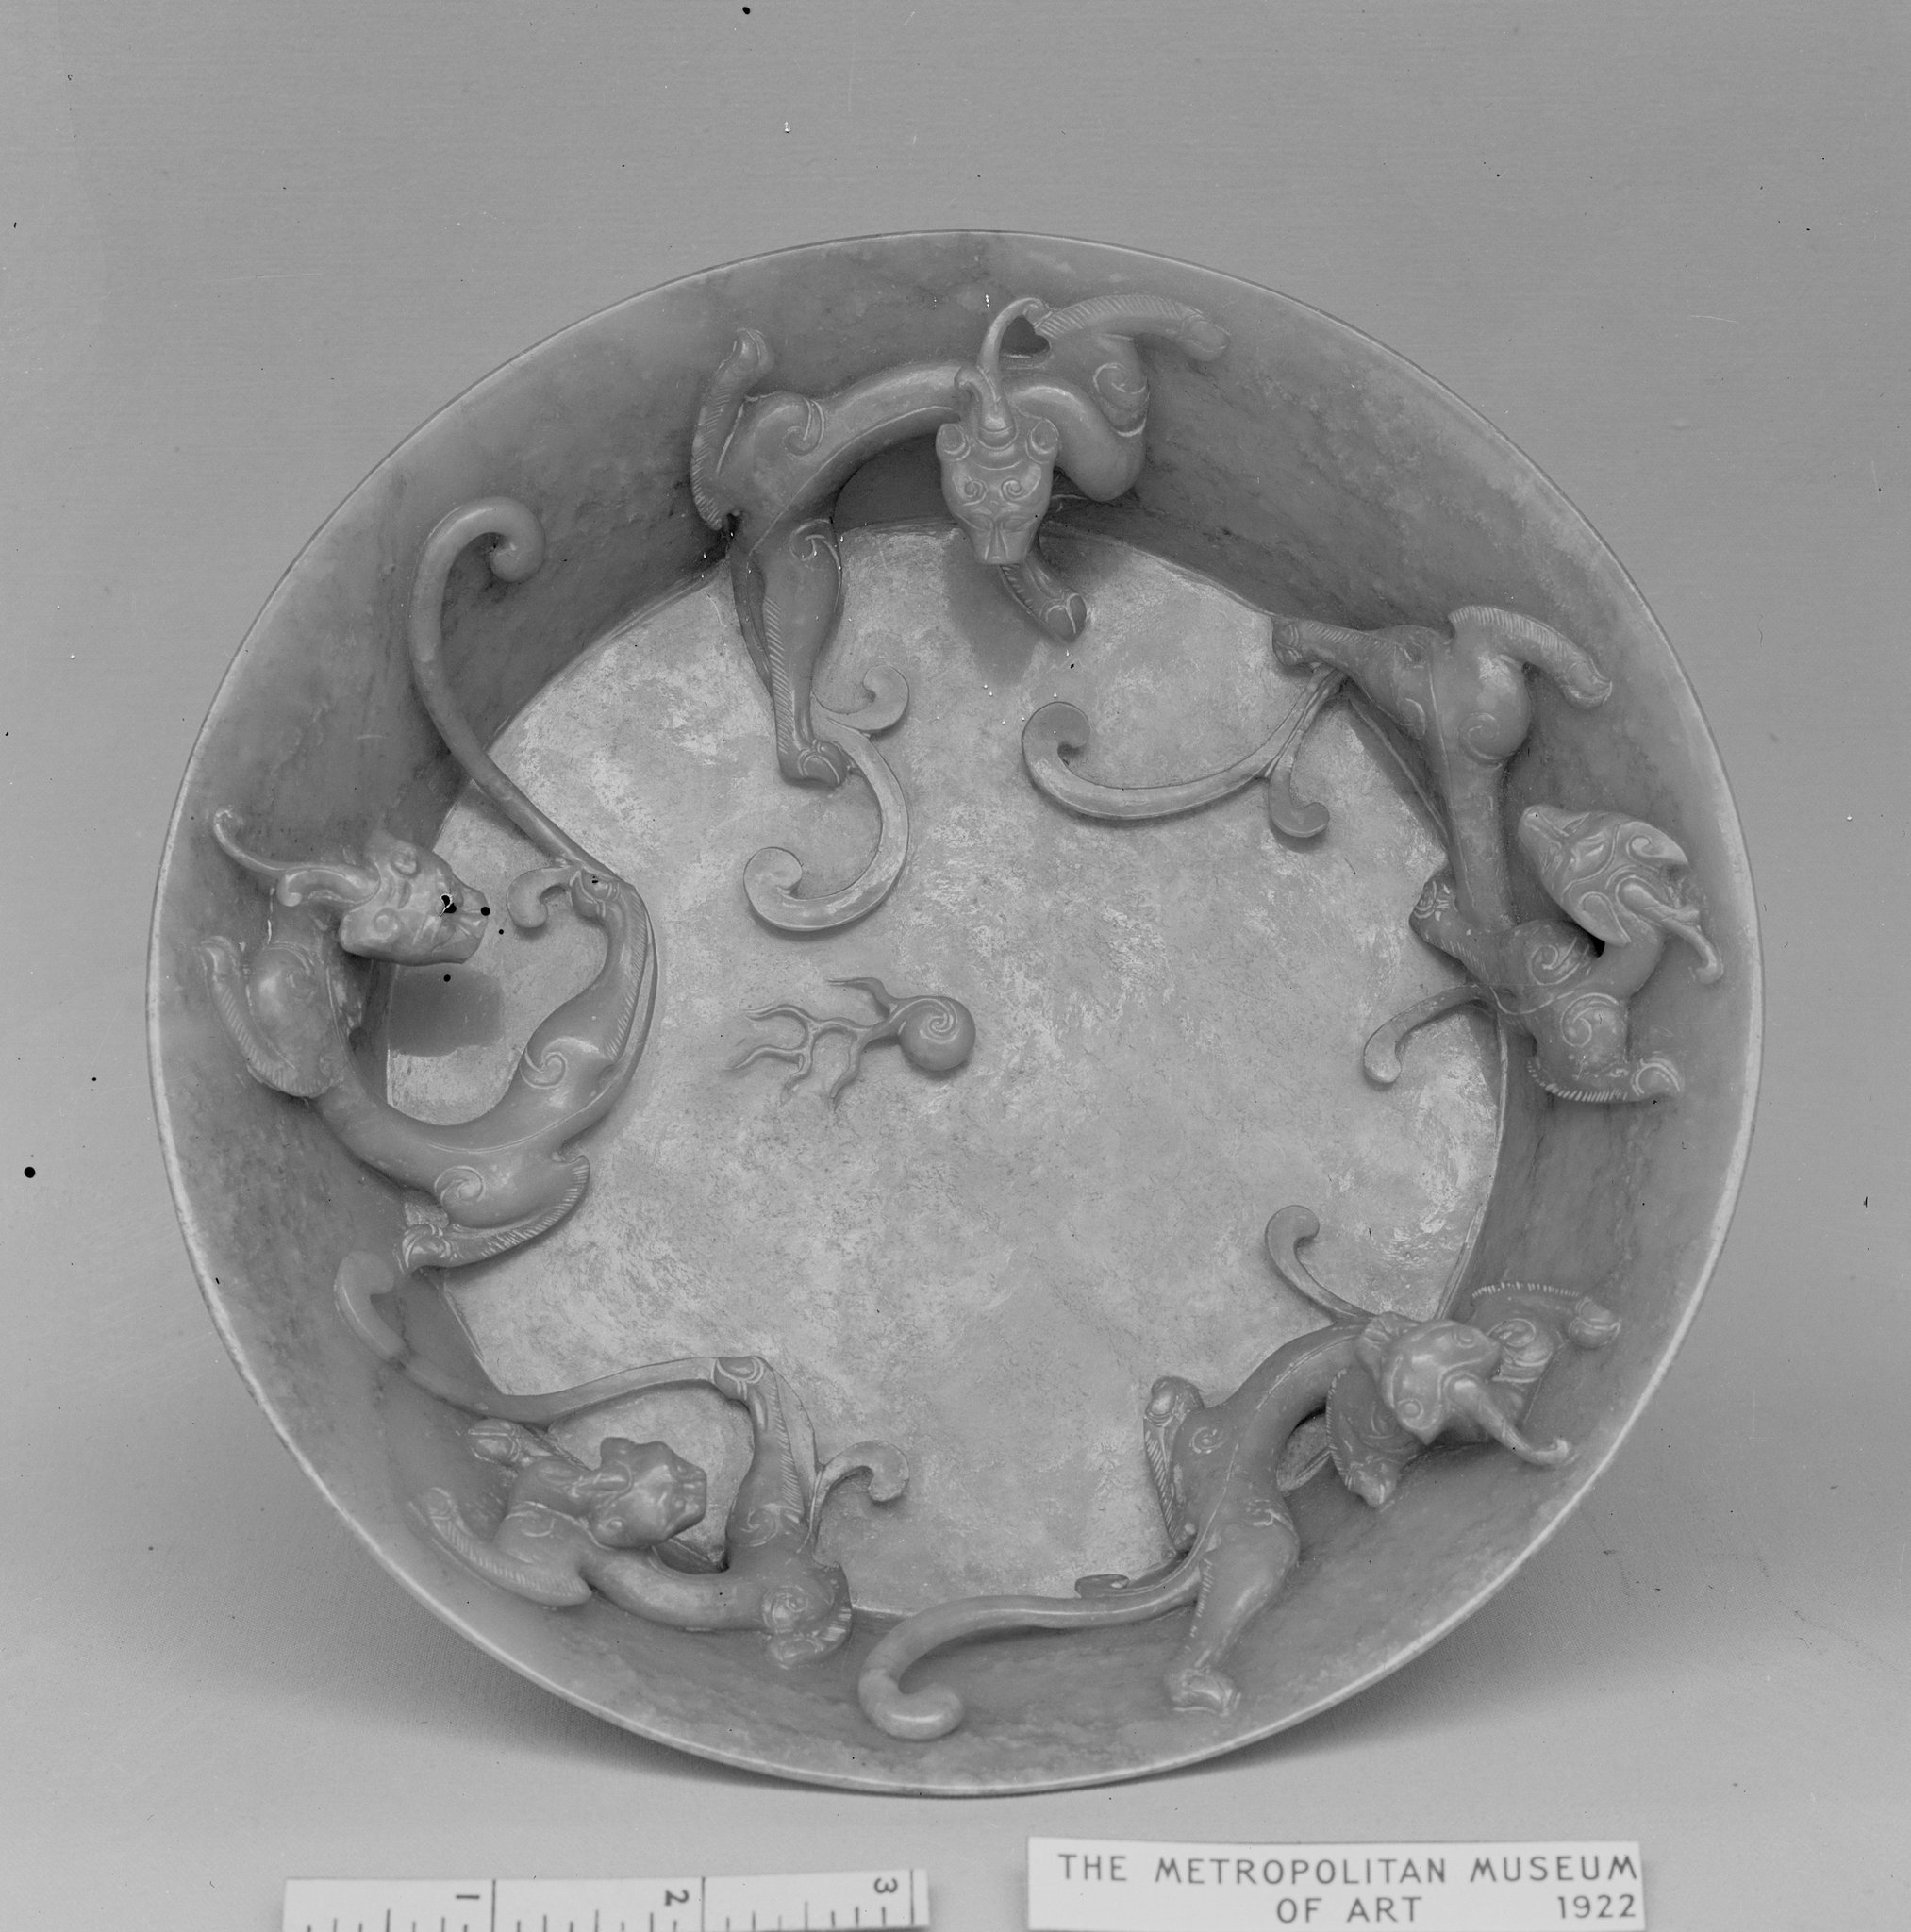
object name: dish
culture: chinese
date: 1368-1744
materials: jade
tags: dragons